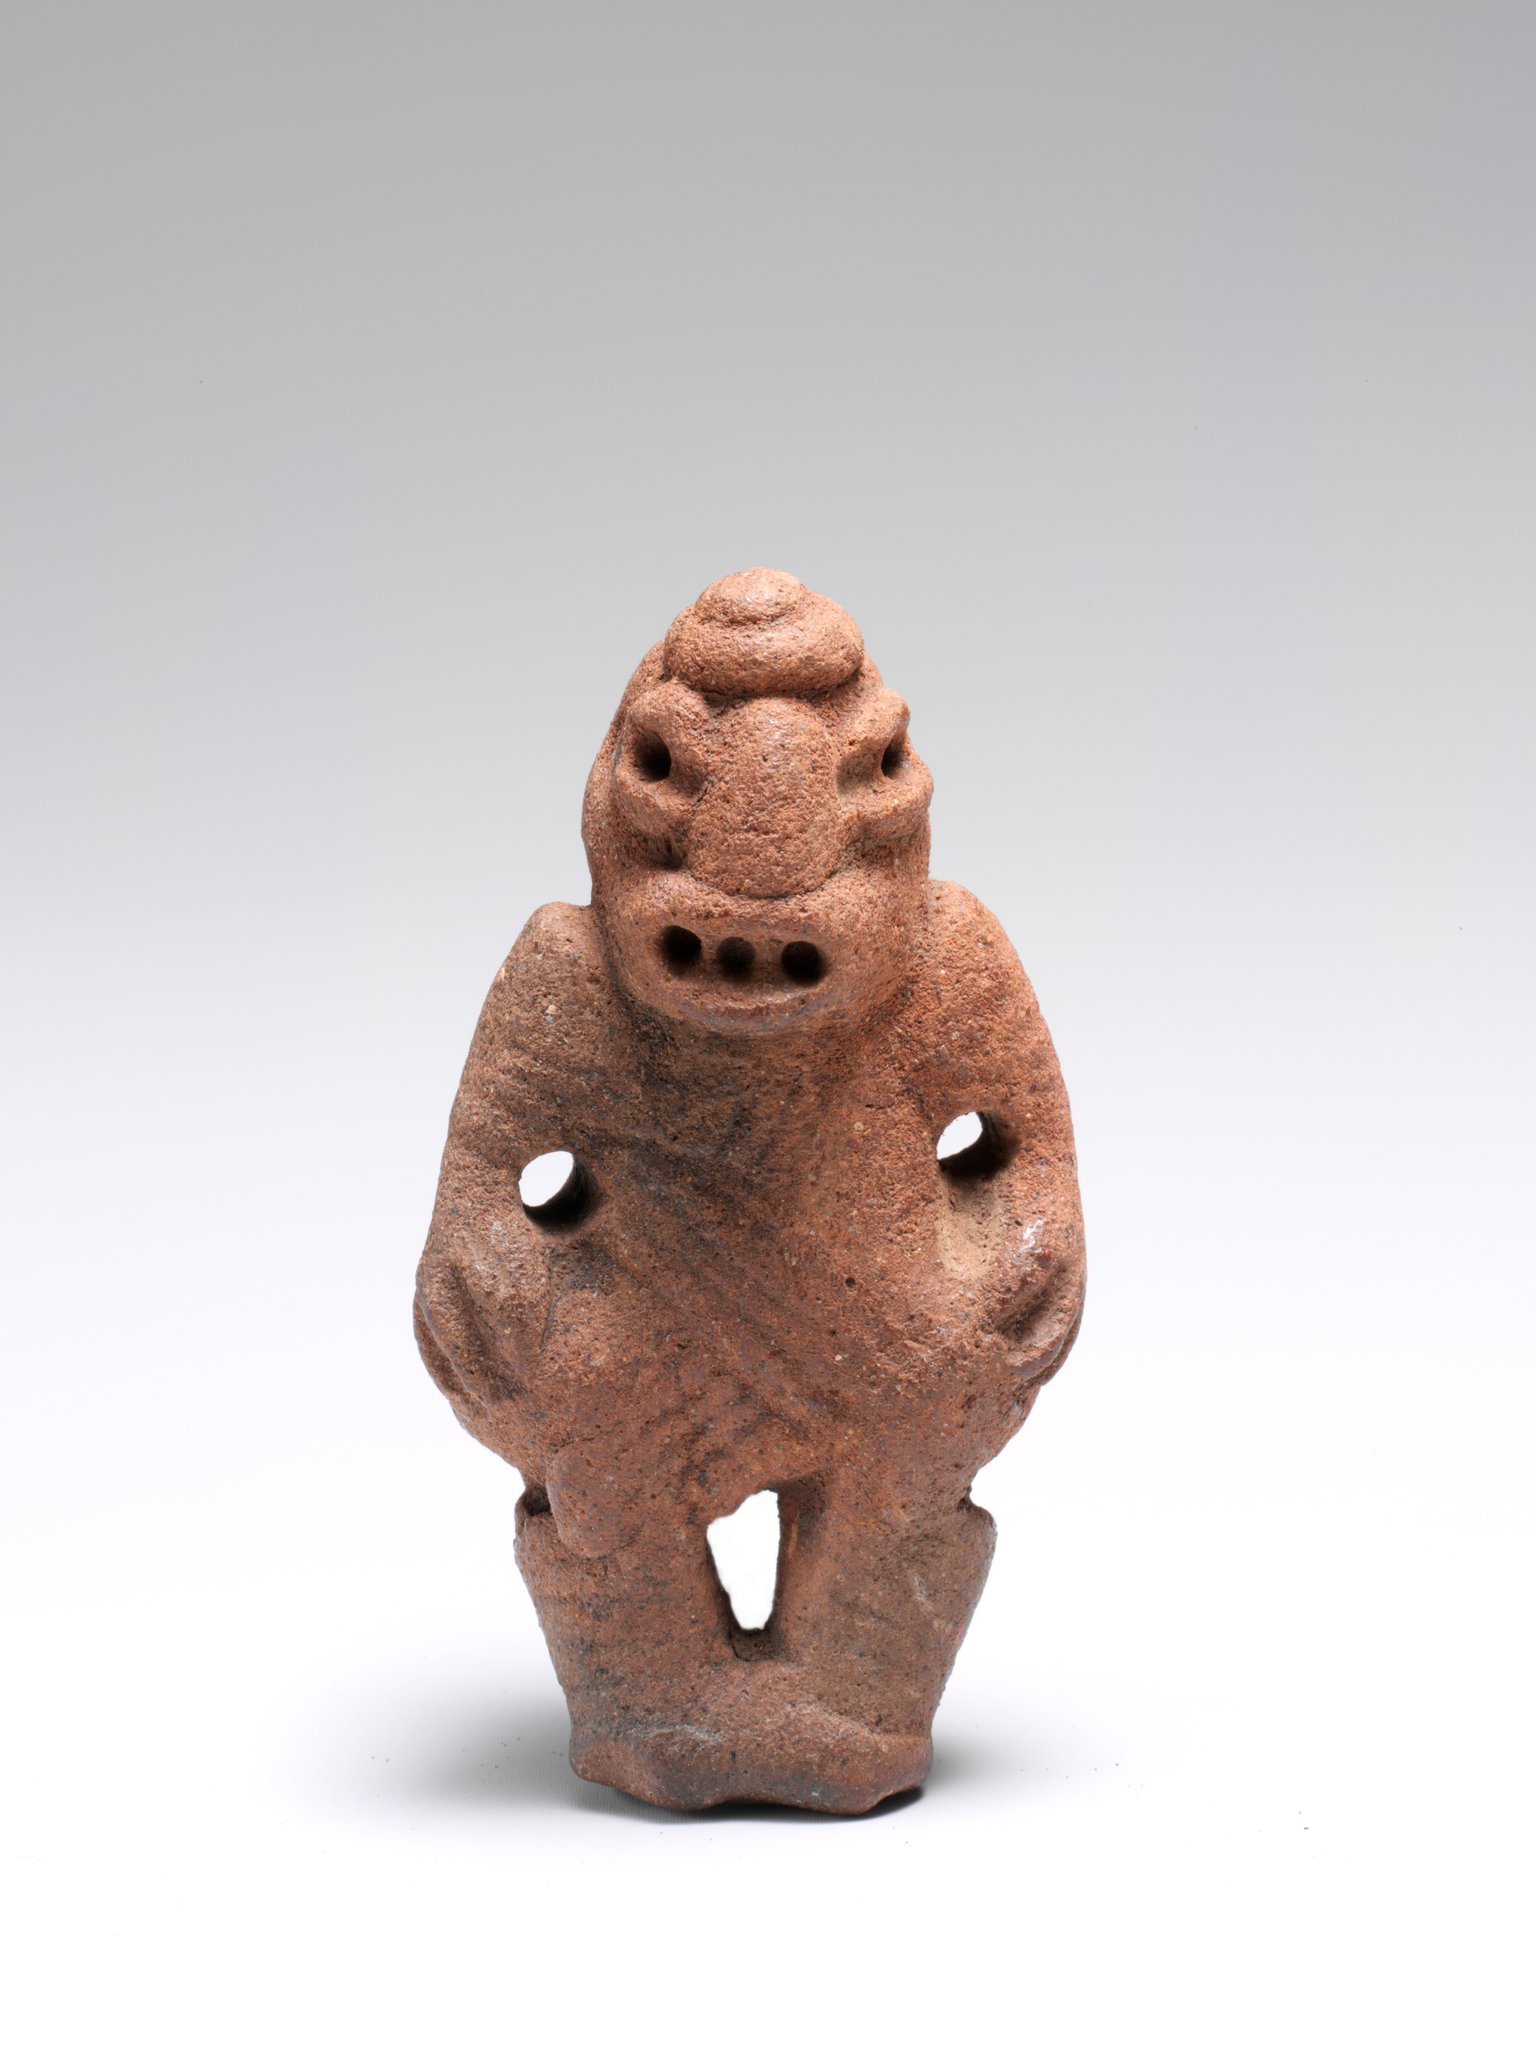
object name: pottery whistle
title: Double Pottery Whistle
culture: costa rican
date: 500 BCE-500 CE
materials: clay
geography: costa rica